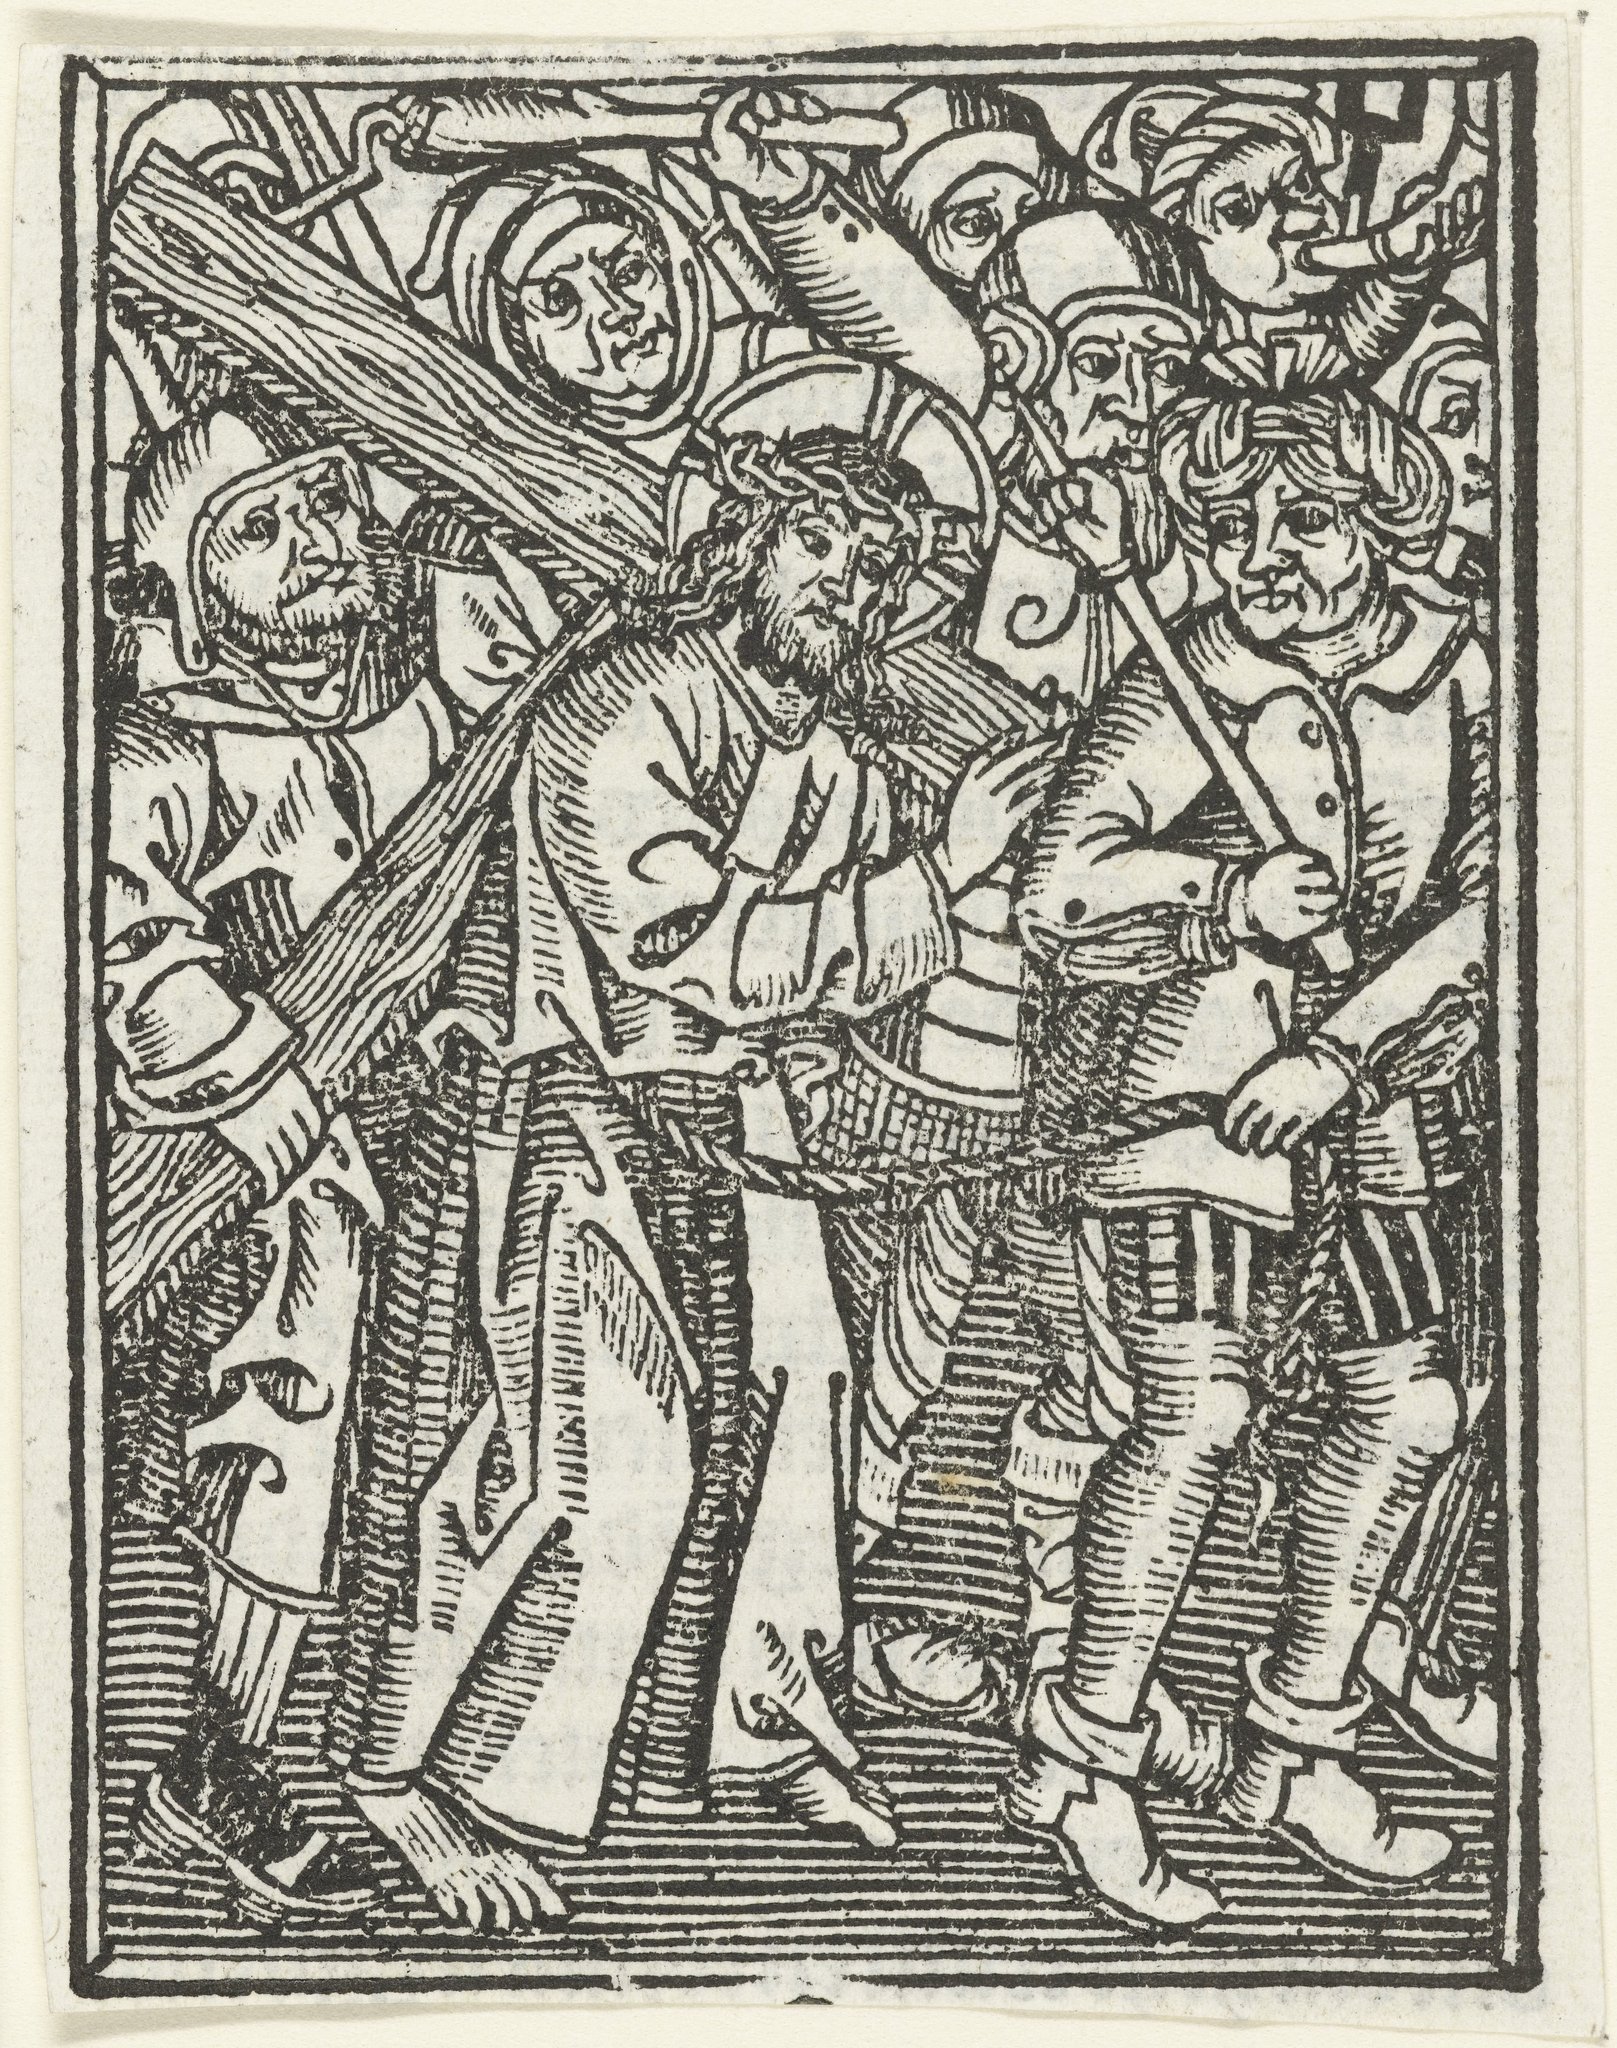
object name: print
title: Kruisdraging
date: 1490-1500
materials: paper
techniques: woodcut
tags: carrying of the cross: christ bearing the cross, alone or with the help of others (e.g. simon the cyrenian)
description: Eén blad van 113 uit Ludolphus de Saxonia, "Dit es dleué ons liefs heeren ihesu christi". Anonieme Nederlandse vertaling. Uitgegeven door Henrick Eckert van Homberch te Antwerpen in 1503. Botke, K. Deze 113 houtsneden, die meestal reeds in vroege Nederlandse boeken gebruikt zijn, worden toegeschreven aan de tweede Meester van Delft, de Meester van de Delbecq-Schreiber-passie en de Meester van de Virgo inter Virgines. In Conway (1884) en in "De gulden passer"(1951) zijn ook eerdere versies opgenomen. Botke, K.